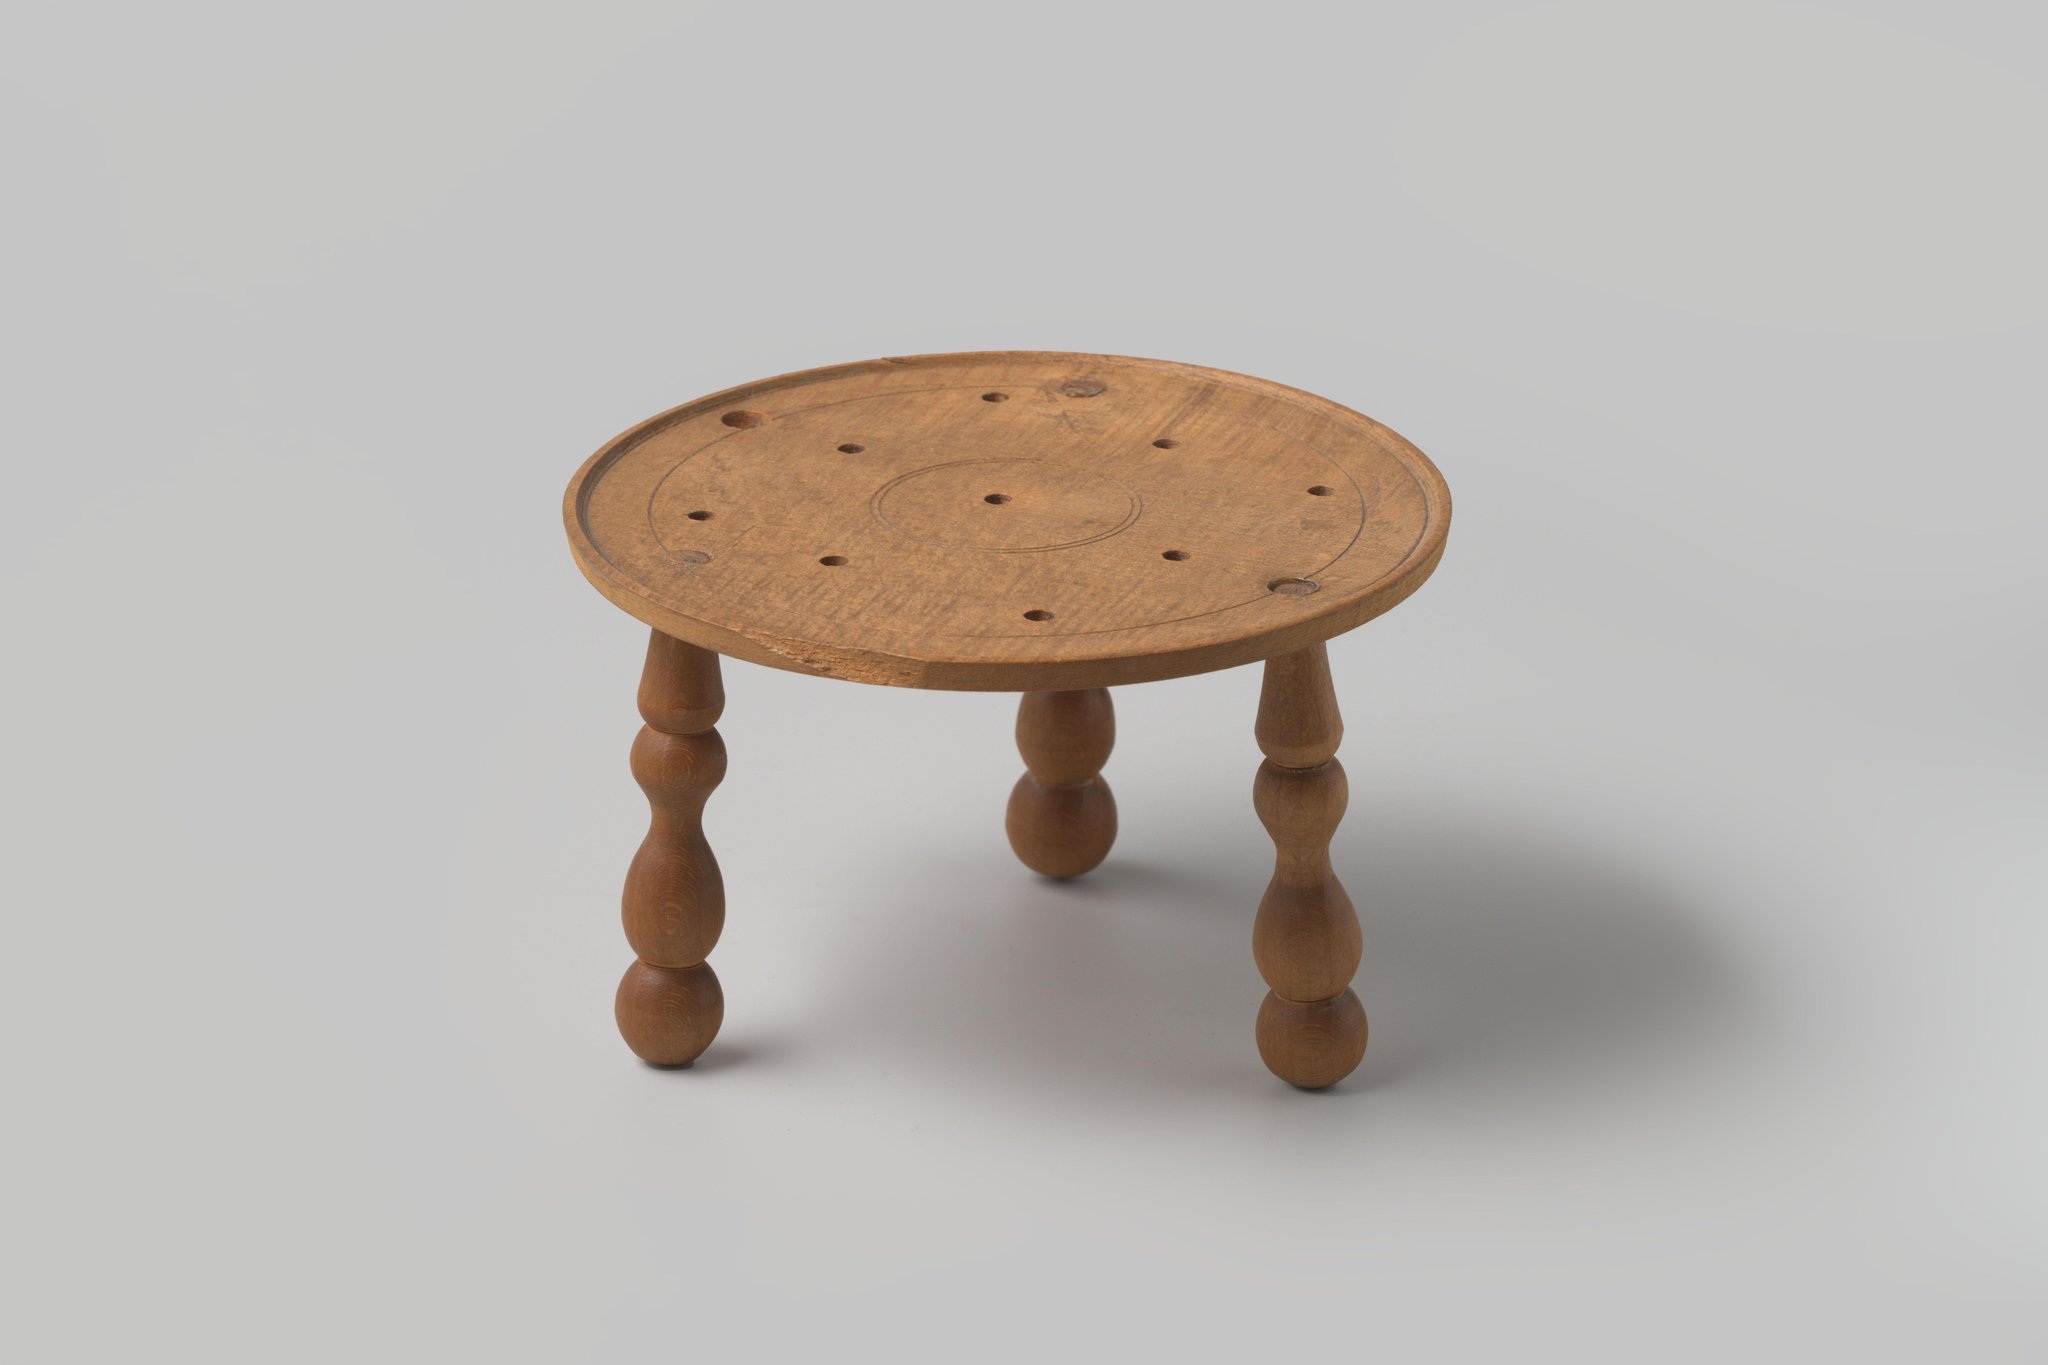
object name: table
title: Tafel, vervaardigd van beukenhout, met een rond blad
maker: Anonymous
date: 1800-1899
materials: wood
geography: netherlands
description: Tafel, vervaardigd van beukenhout, het blad bestaat uit een ronde schijf met een opstaande rand en gedraaide ringen, waarin in een vierkant patroon negen gaten zijn geboord en daaromheen vier groter gaten, waarin de drie gedraaide poten met bollen en balusters zijn gestoken.